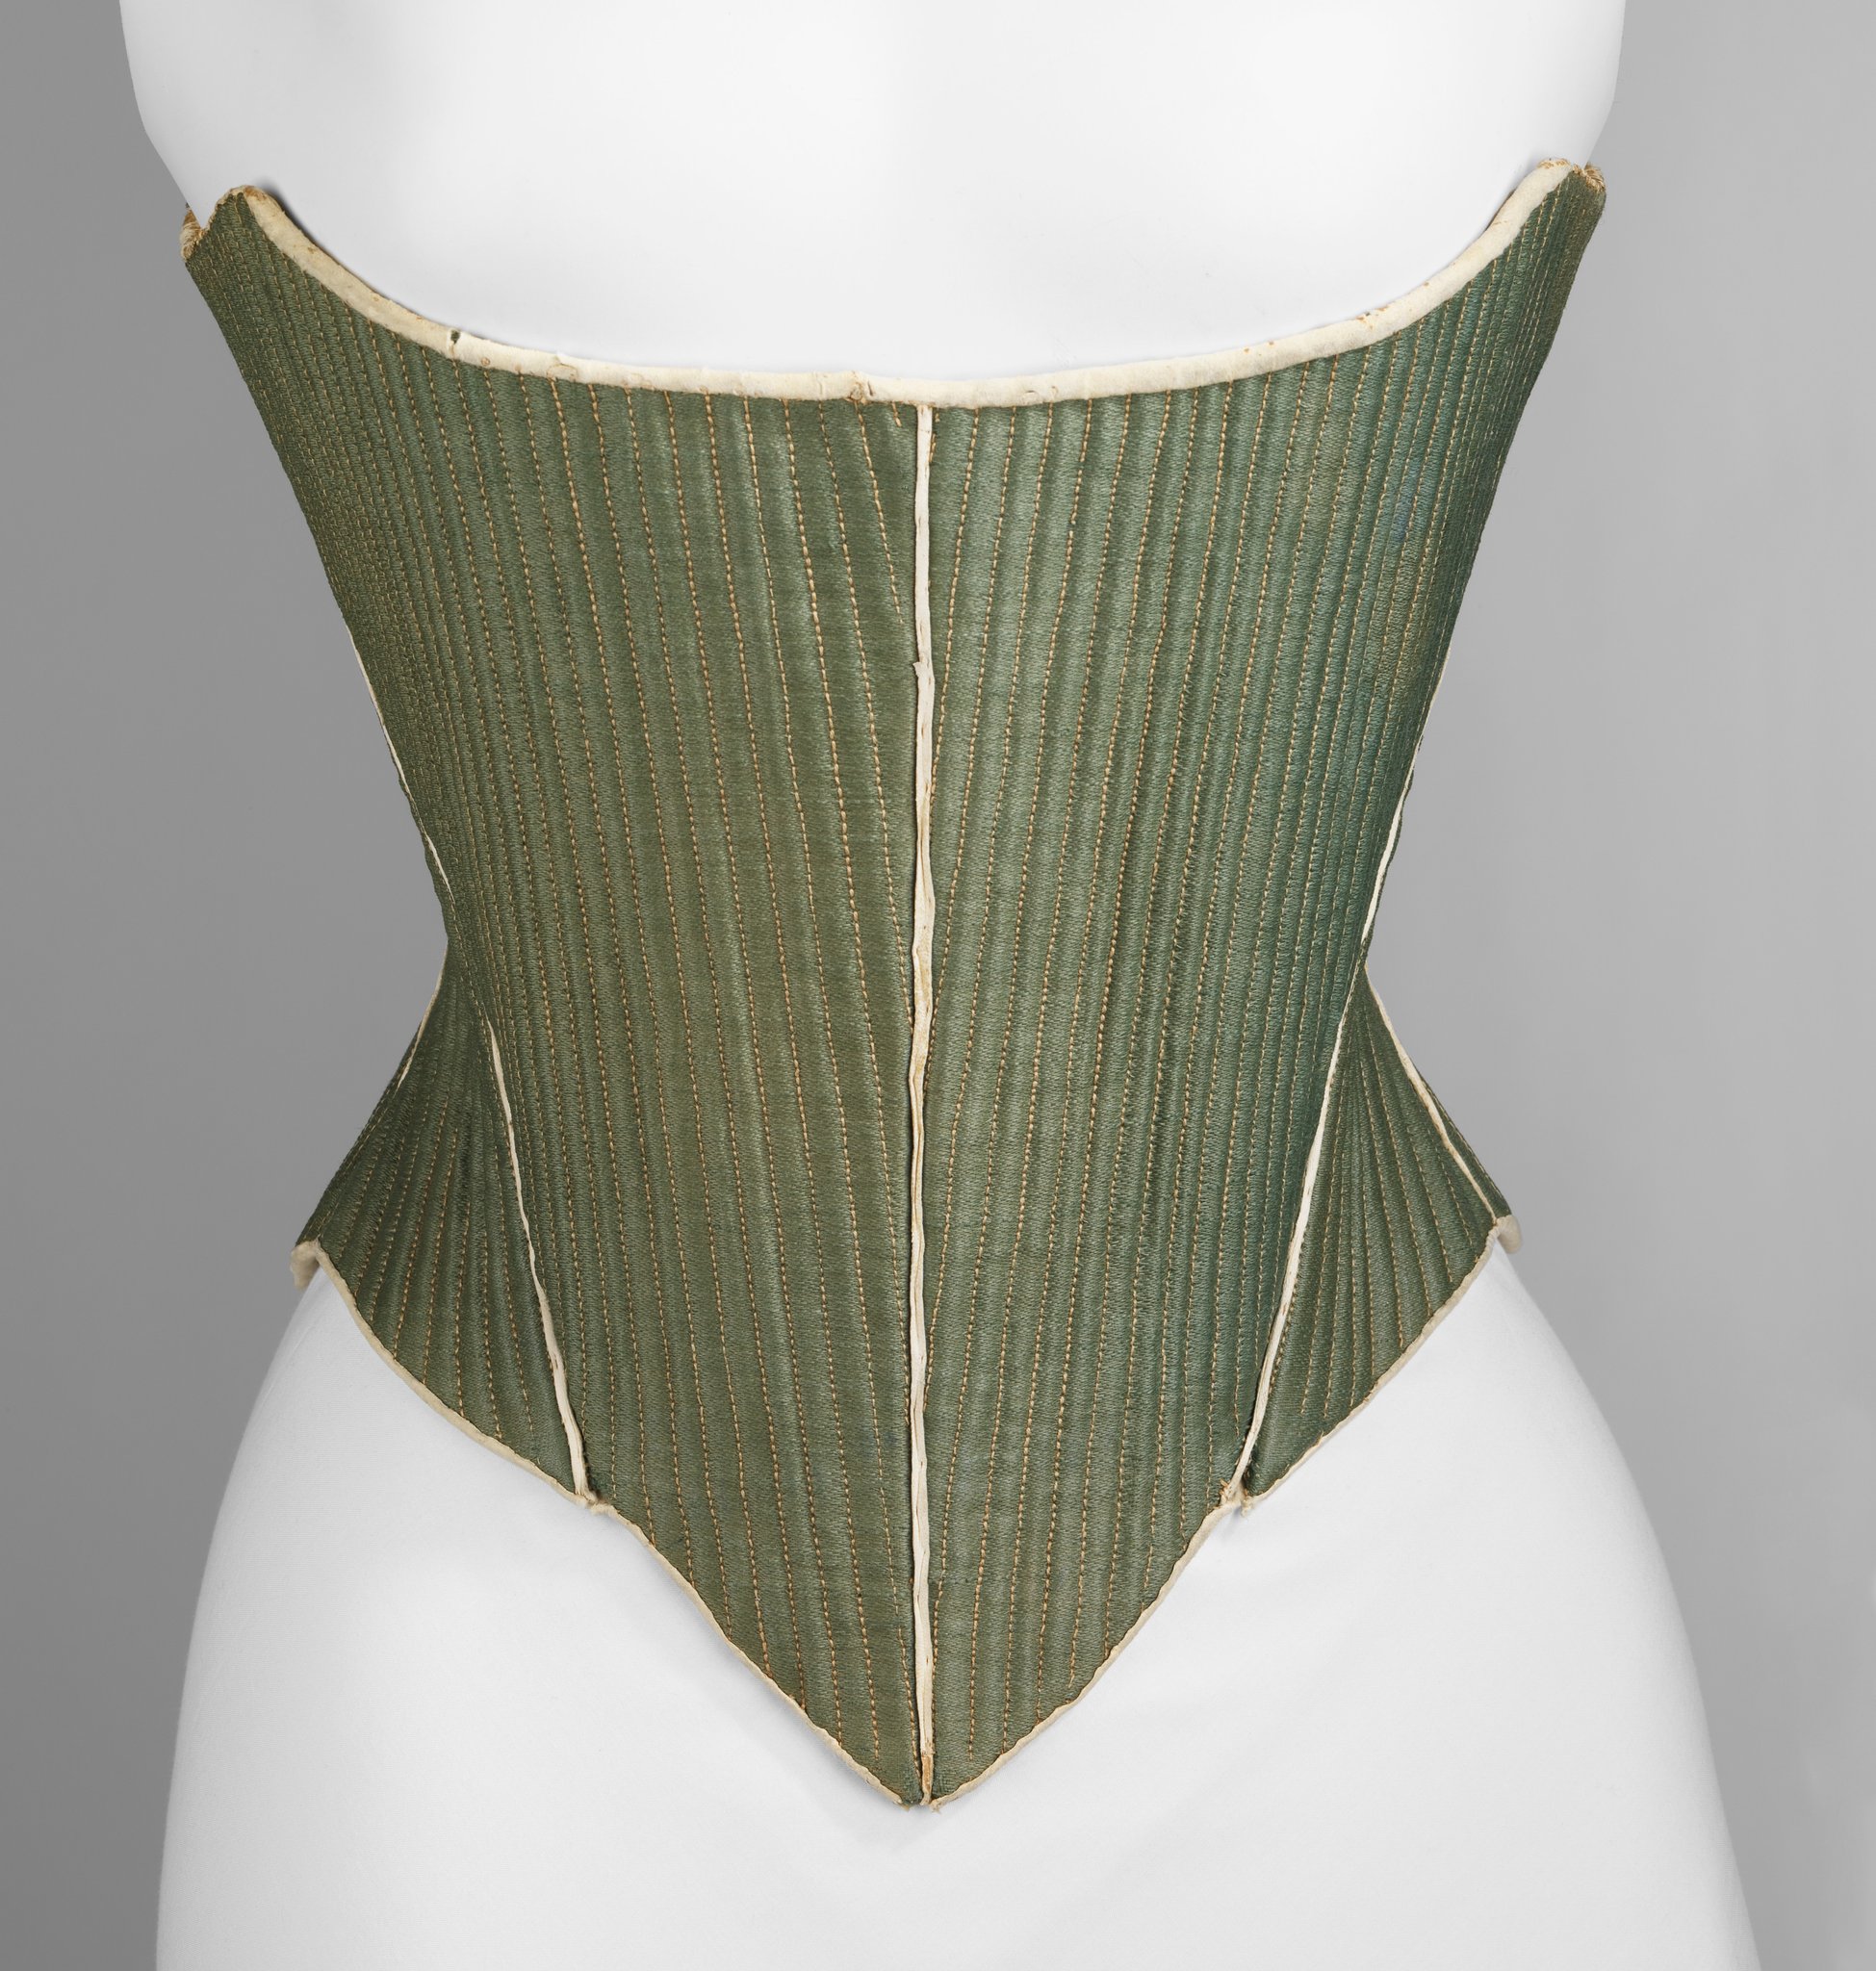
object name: corset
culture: american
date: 1780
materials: leather, linen, wool